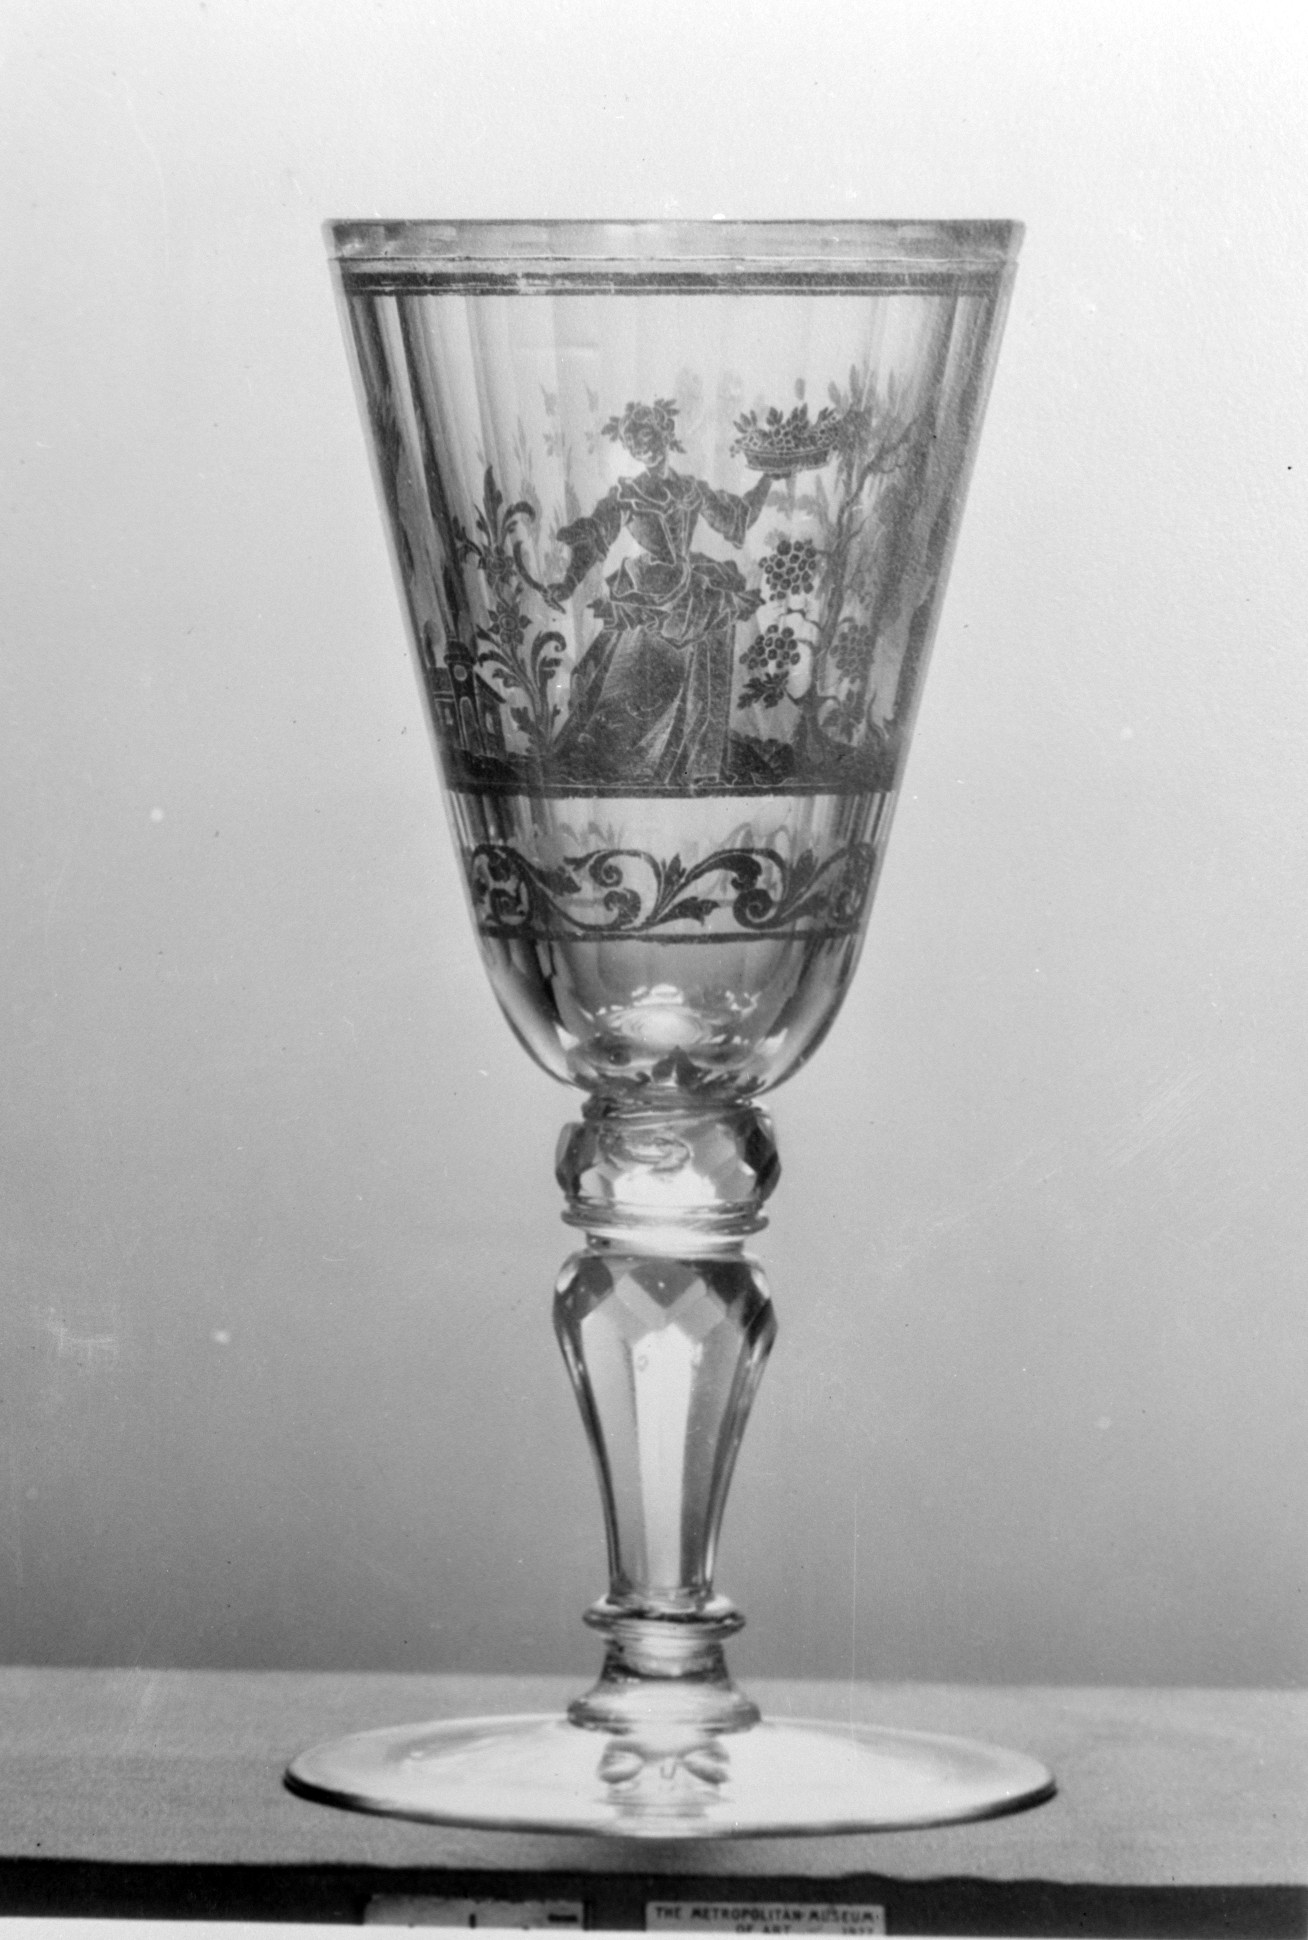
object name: wineglass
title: Allegory of the Seasons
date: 1730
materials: glass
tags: grapes,women